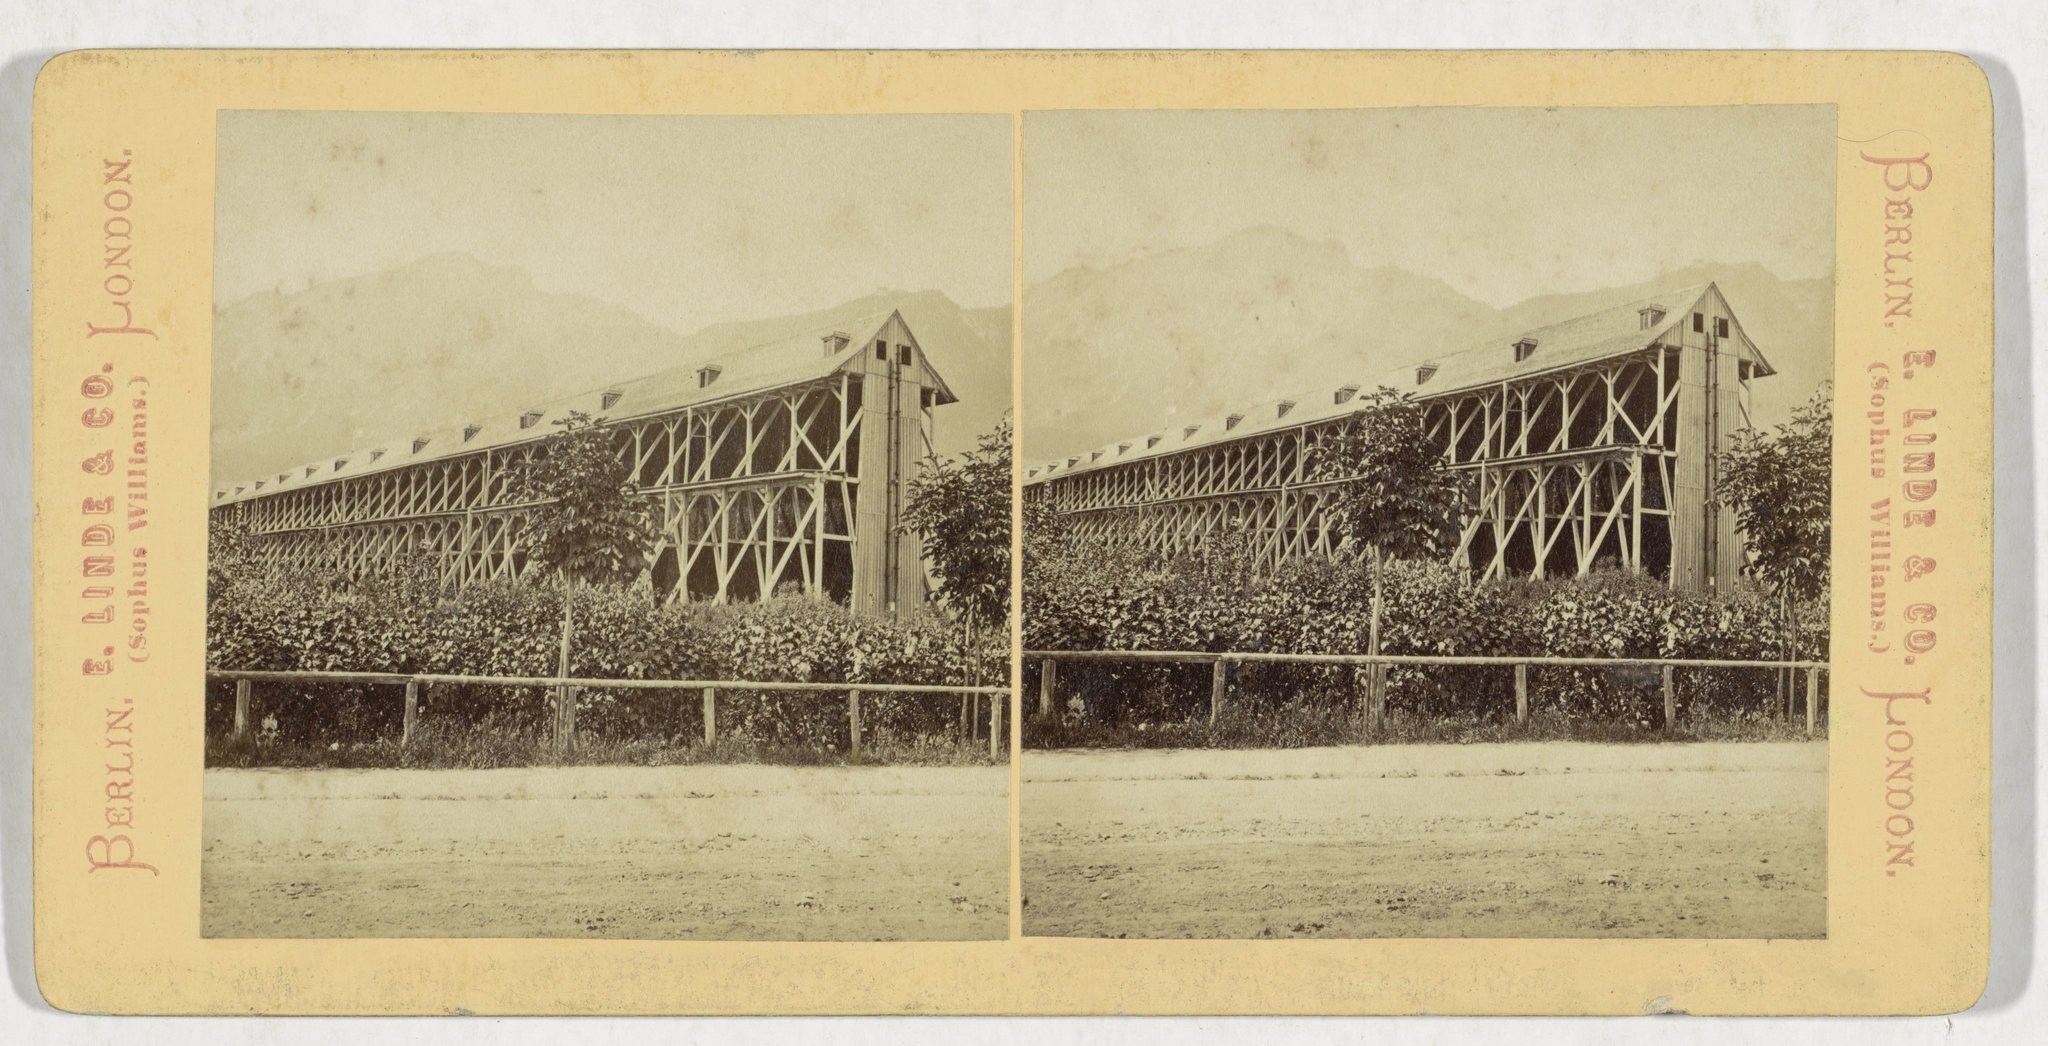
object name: stereograph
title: Gradirwerke bei Reichenhall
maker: Anonymous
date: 1868-1890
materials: cardboard, paper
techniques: albumen print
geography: bad reichenhall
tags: salt, landscape with other man-made constructions not mentioned above, e.g.: graveyards, playgrounds, etc.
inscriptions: number: ‘No 9.’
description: Een gradeerwerk is een installatie ten behoeve van de zoutwinning. Gradeerwerken worden behalve voor de zoutwinning ook gebruikt als kuuroorden, vanwege de (verondersteld) gunstige eigenschappen van de zilte lucht, die doet denken aan zeelucht.